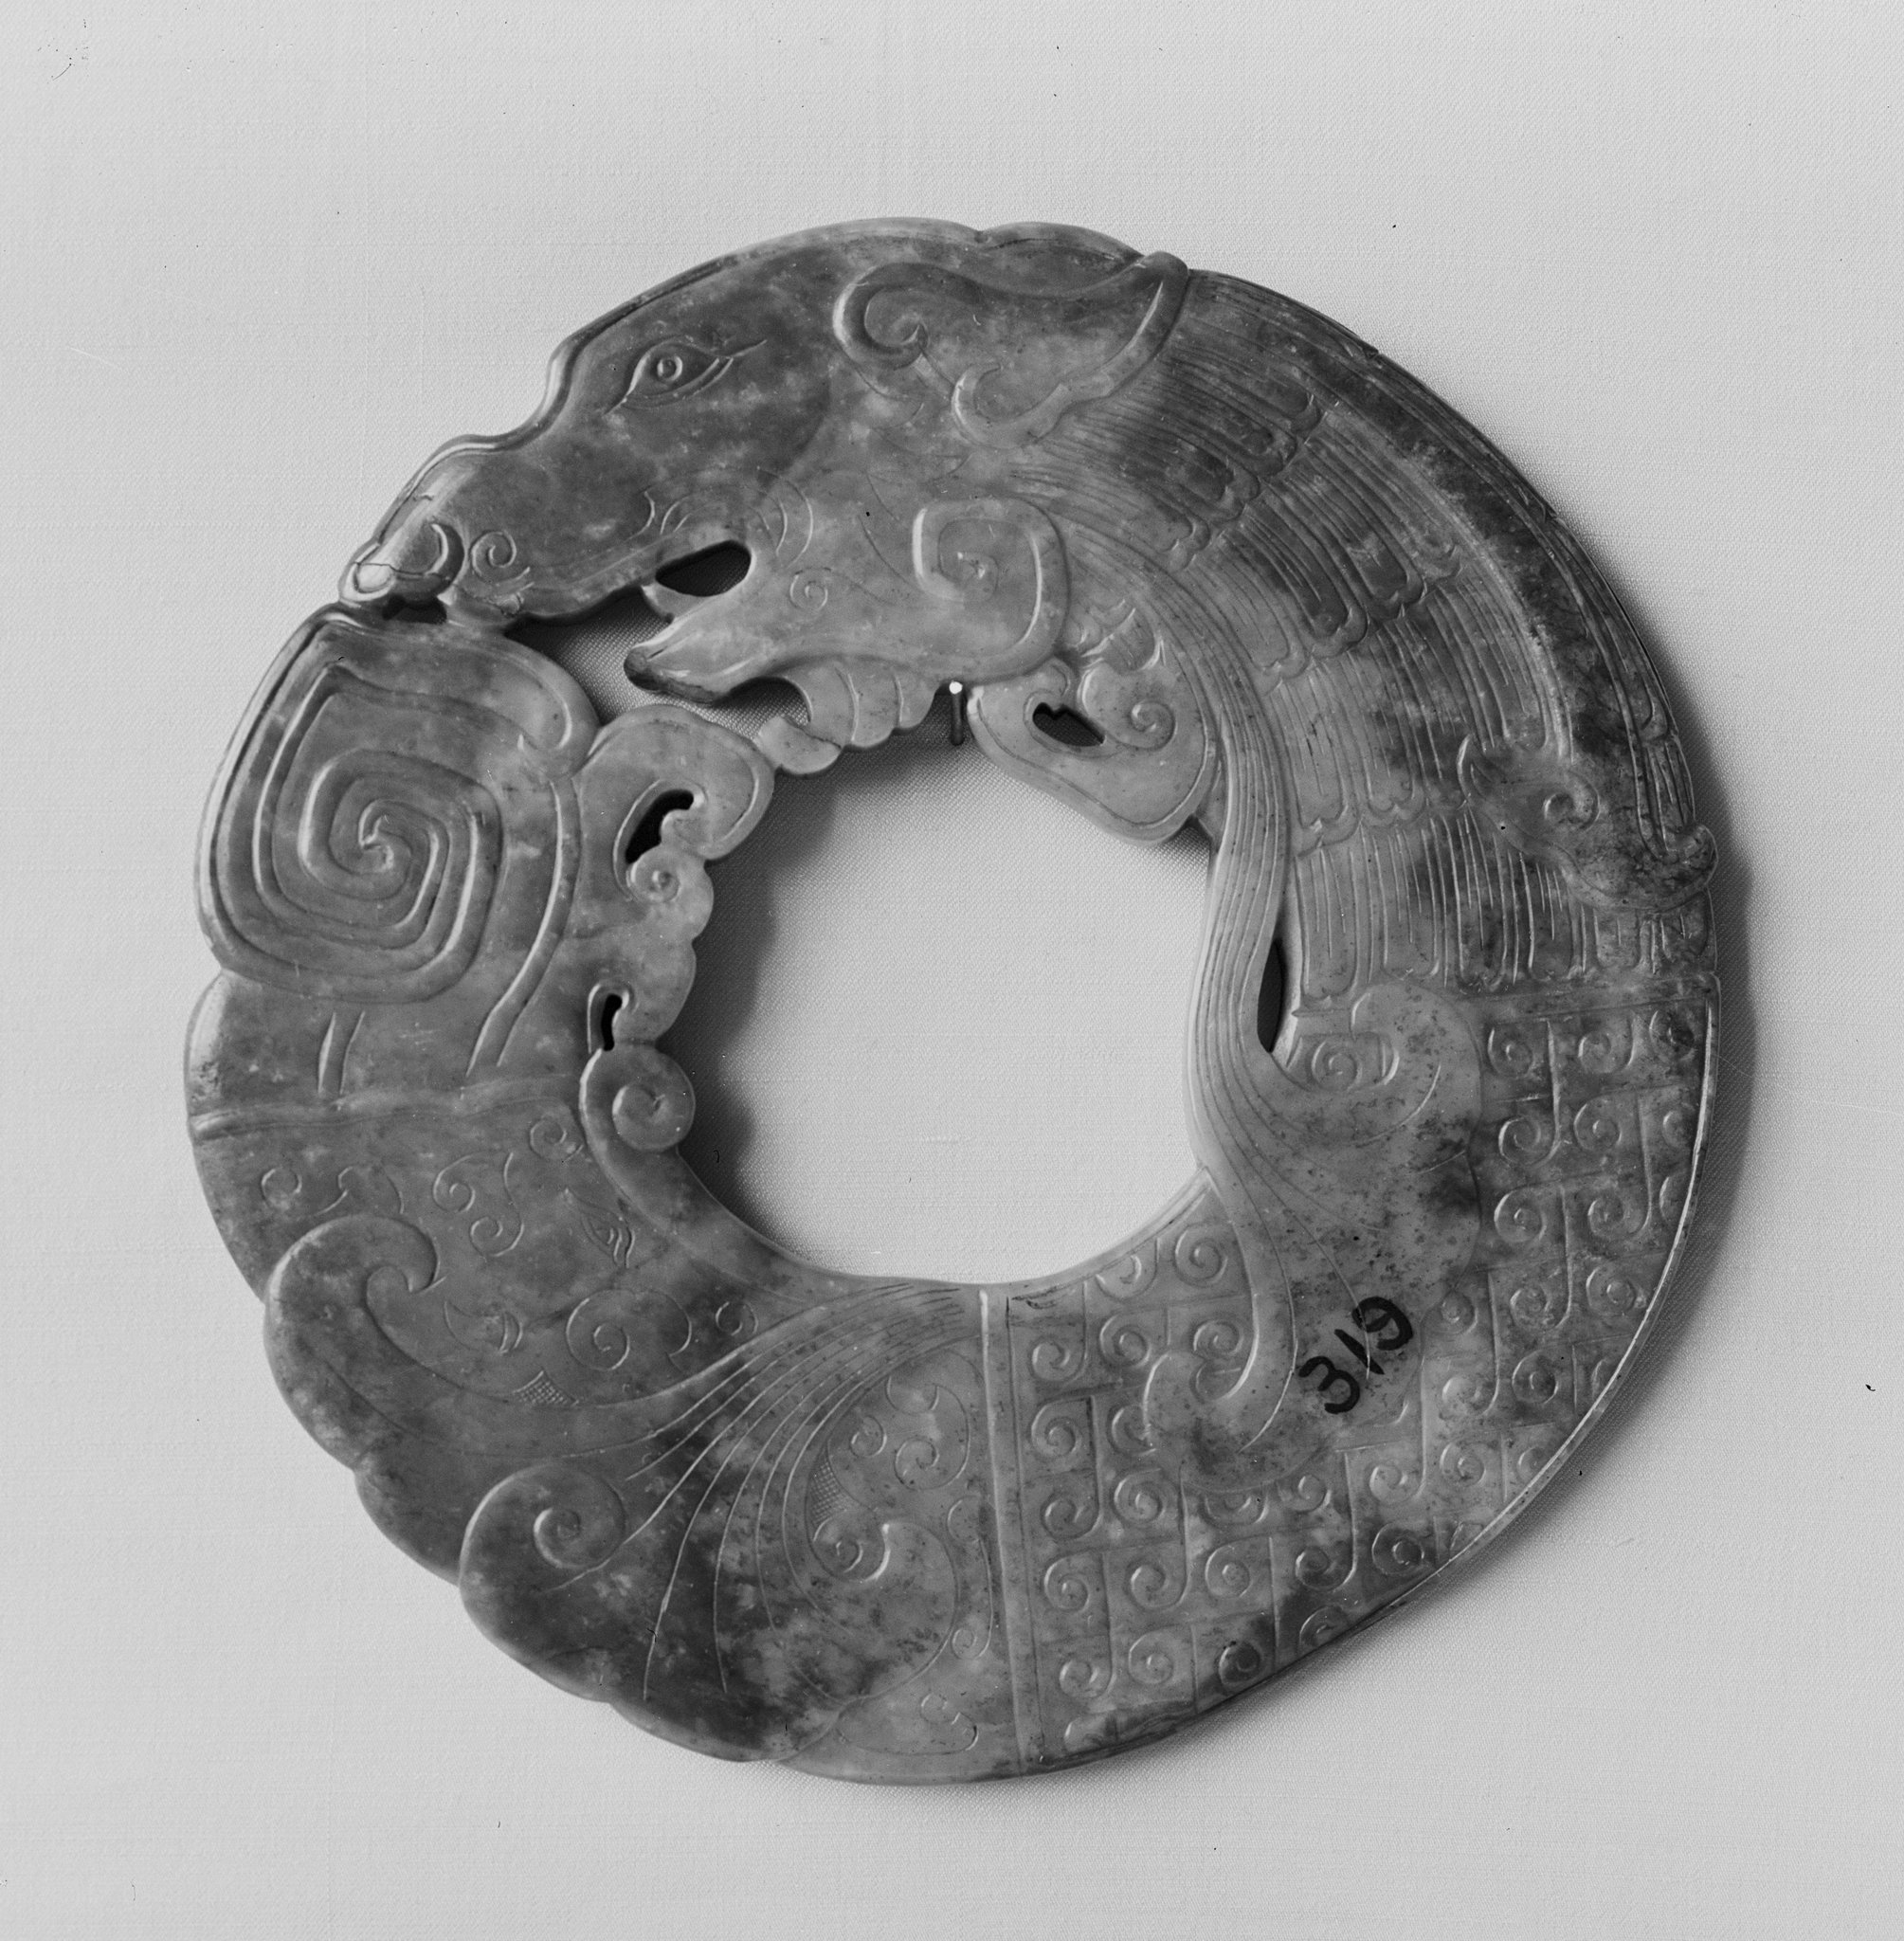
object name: tablet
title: Circular Pierced Tablet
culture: chinese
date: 206 BCE-220 CE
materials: jade